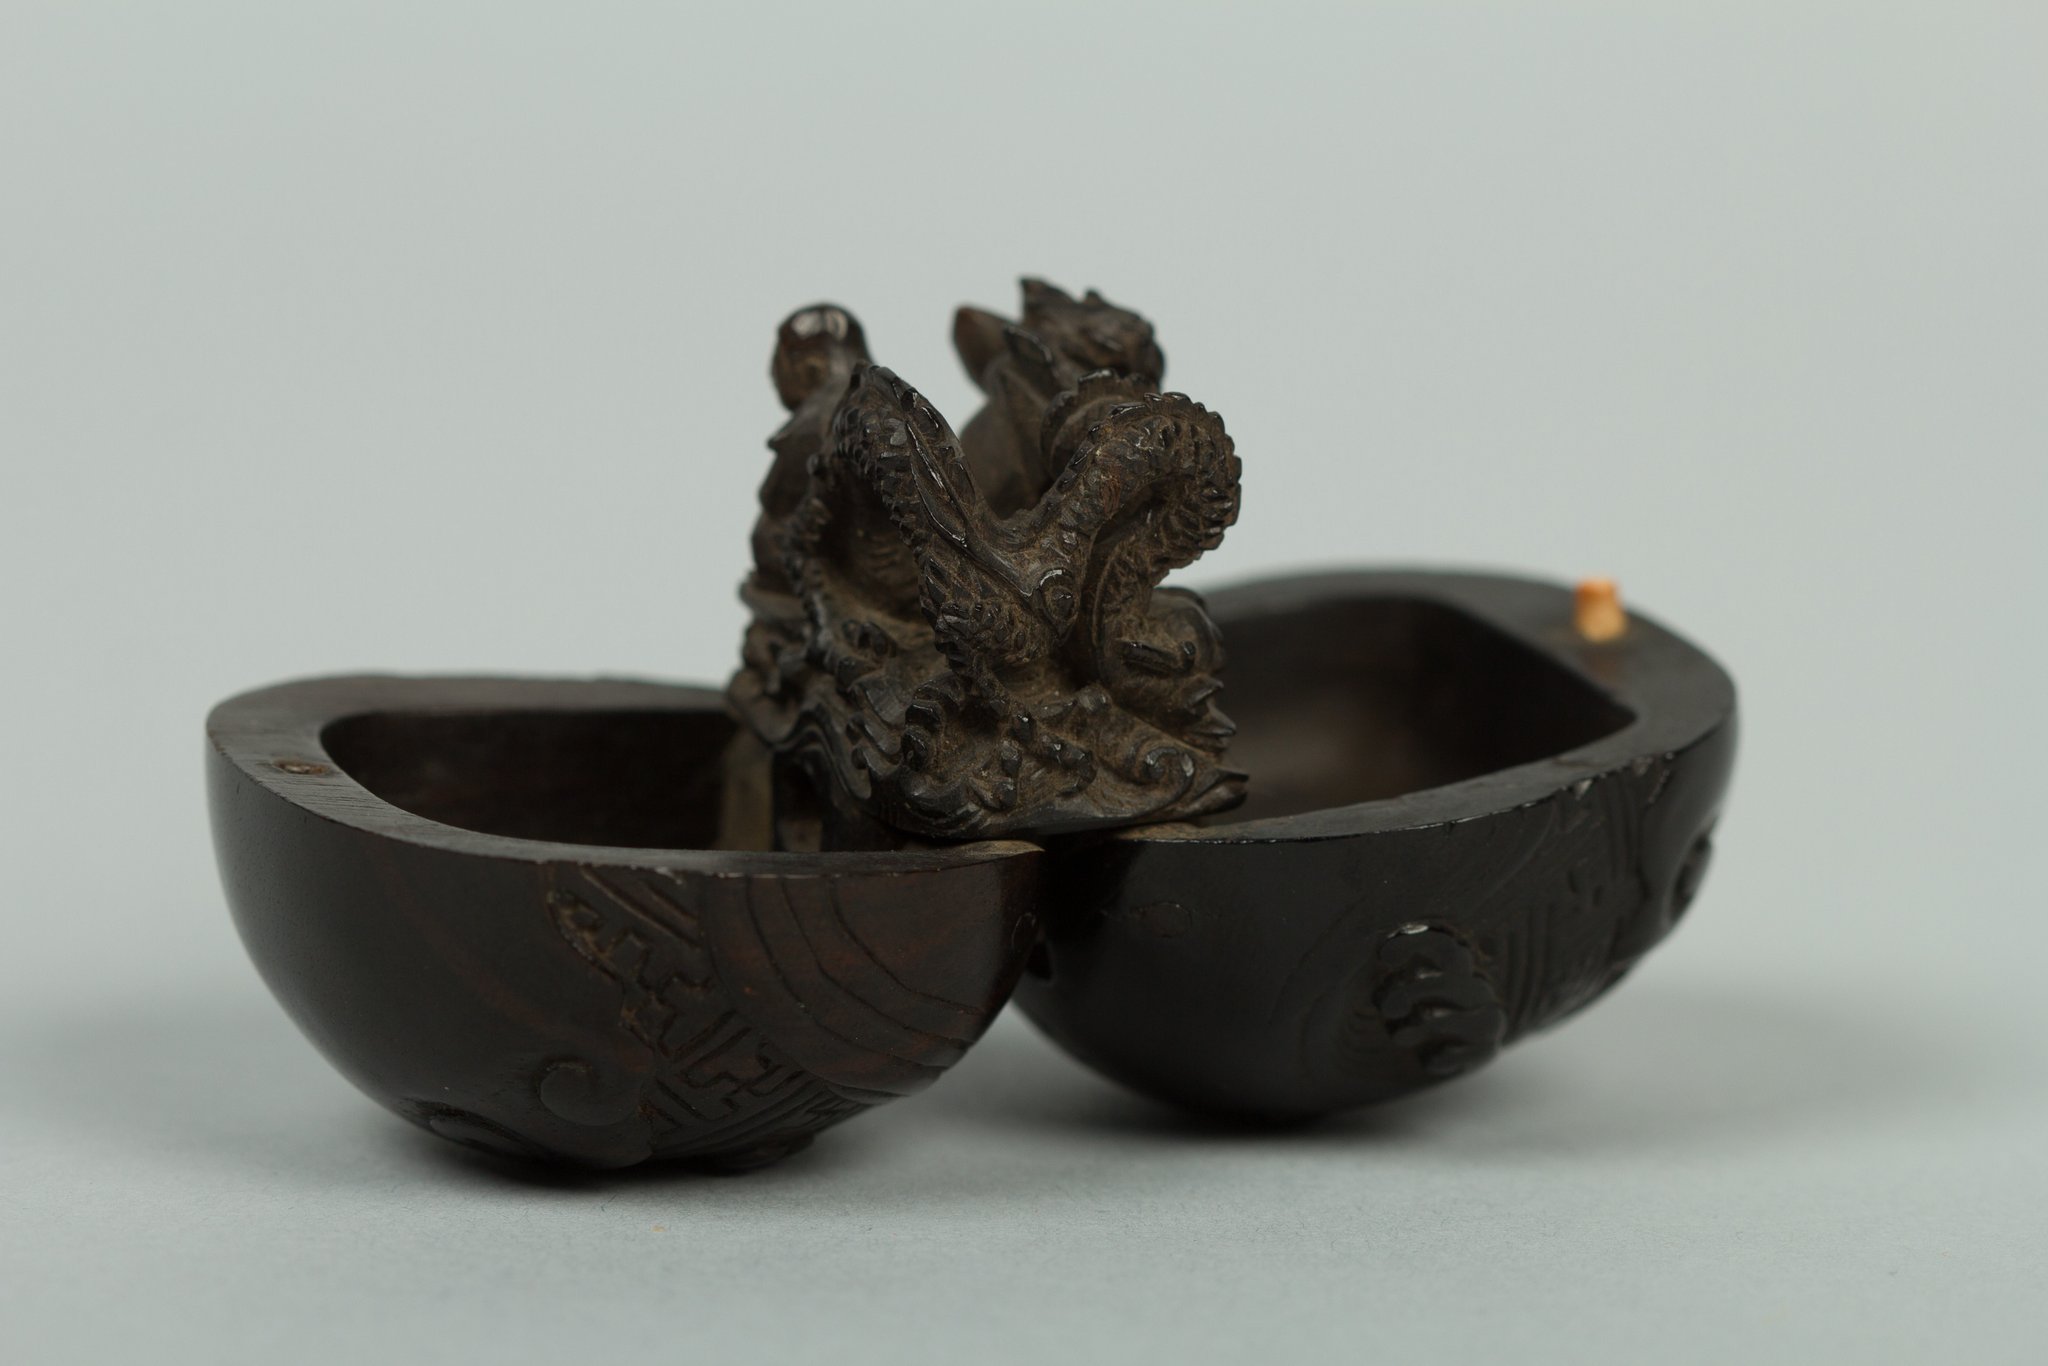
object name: netsuke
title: Netsuke Containing Dragon and Figures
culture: japanese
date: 1801-1900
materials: wood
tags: dragons